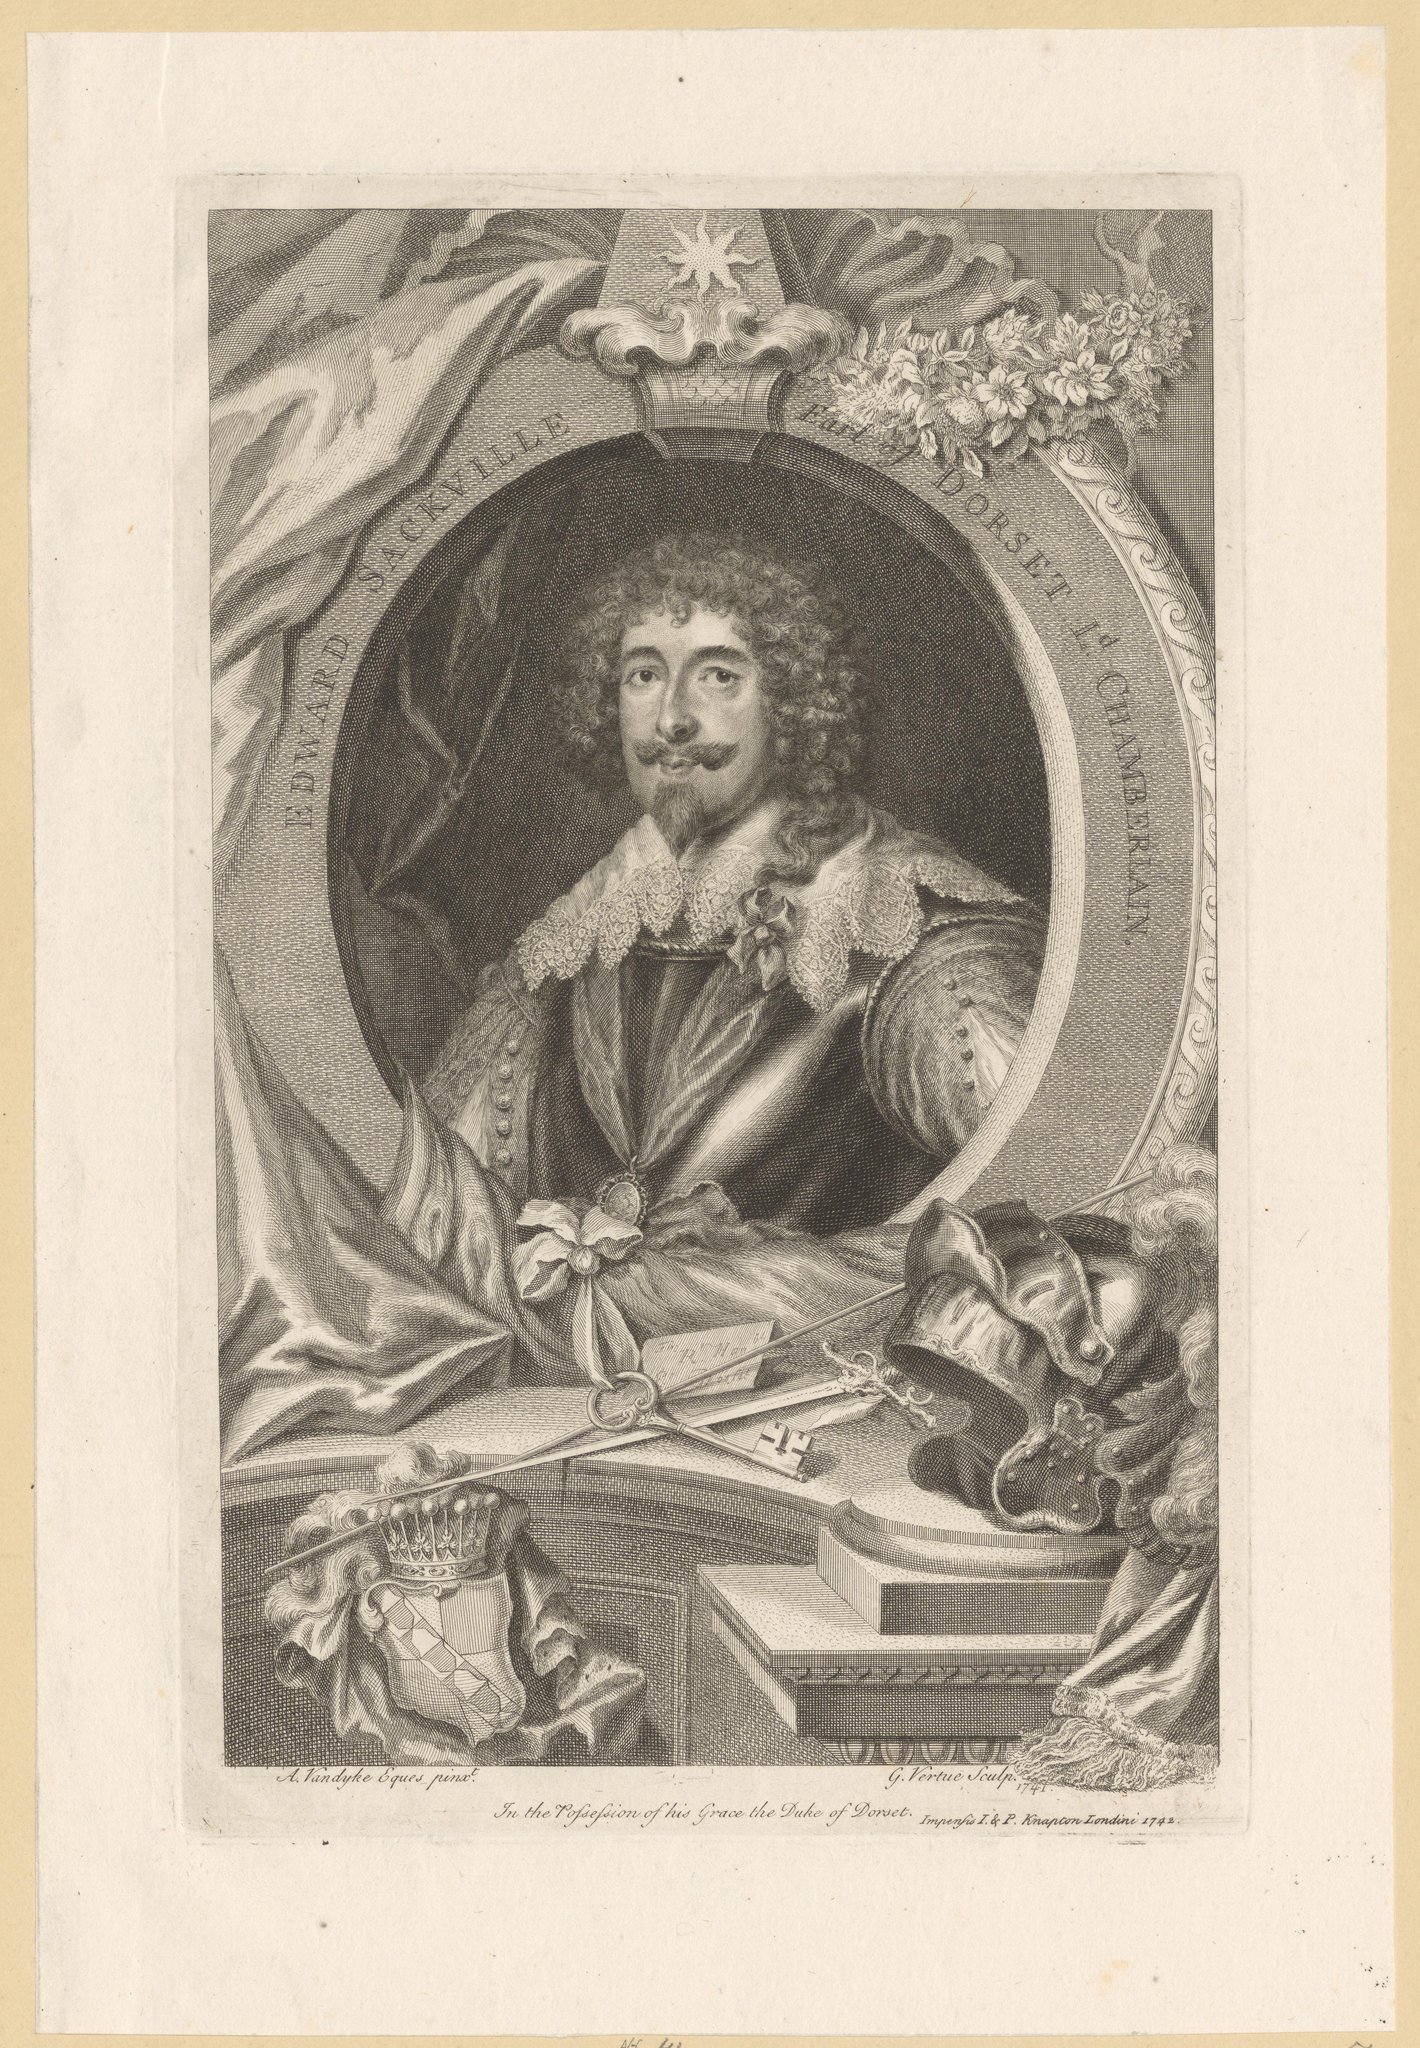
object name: print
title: Portret van Edward Sackville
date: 1741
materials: paper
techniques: engraving, etching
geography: london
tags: politician, armour, historical persons, key, politician, e.g. party leader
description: Prent gebruikt in: Birch, Thomas. The heads of illustrious persons of Great Britain (...). Londen: John & Paul Knapton, 1747, p. 80.